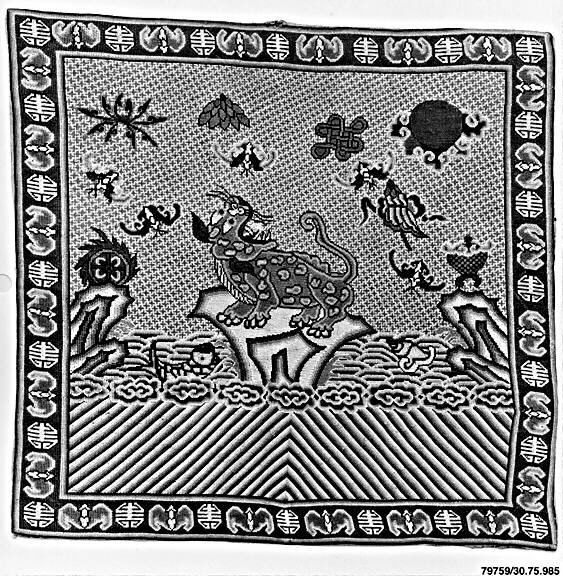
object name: rank badge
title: Rank Badge with Leopard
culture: chinese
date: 1801-1900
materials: canvas, silk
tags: bats,fish,leopards